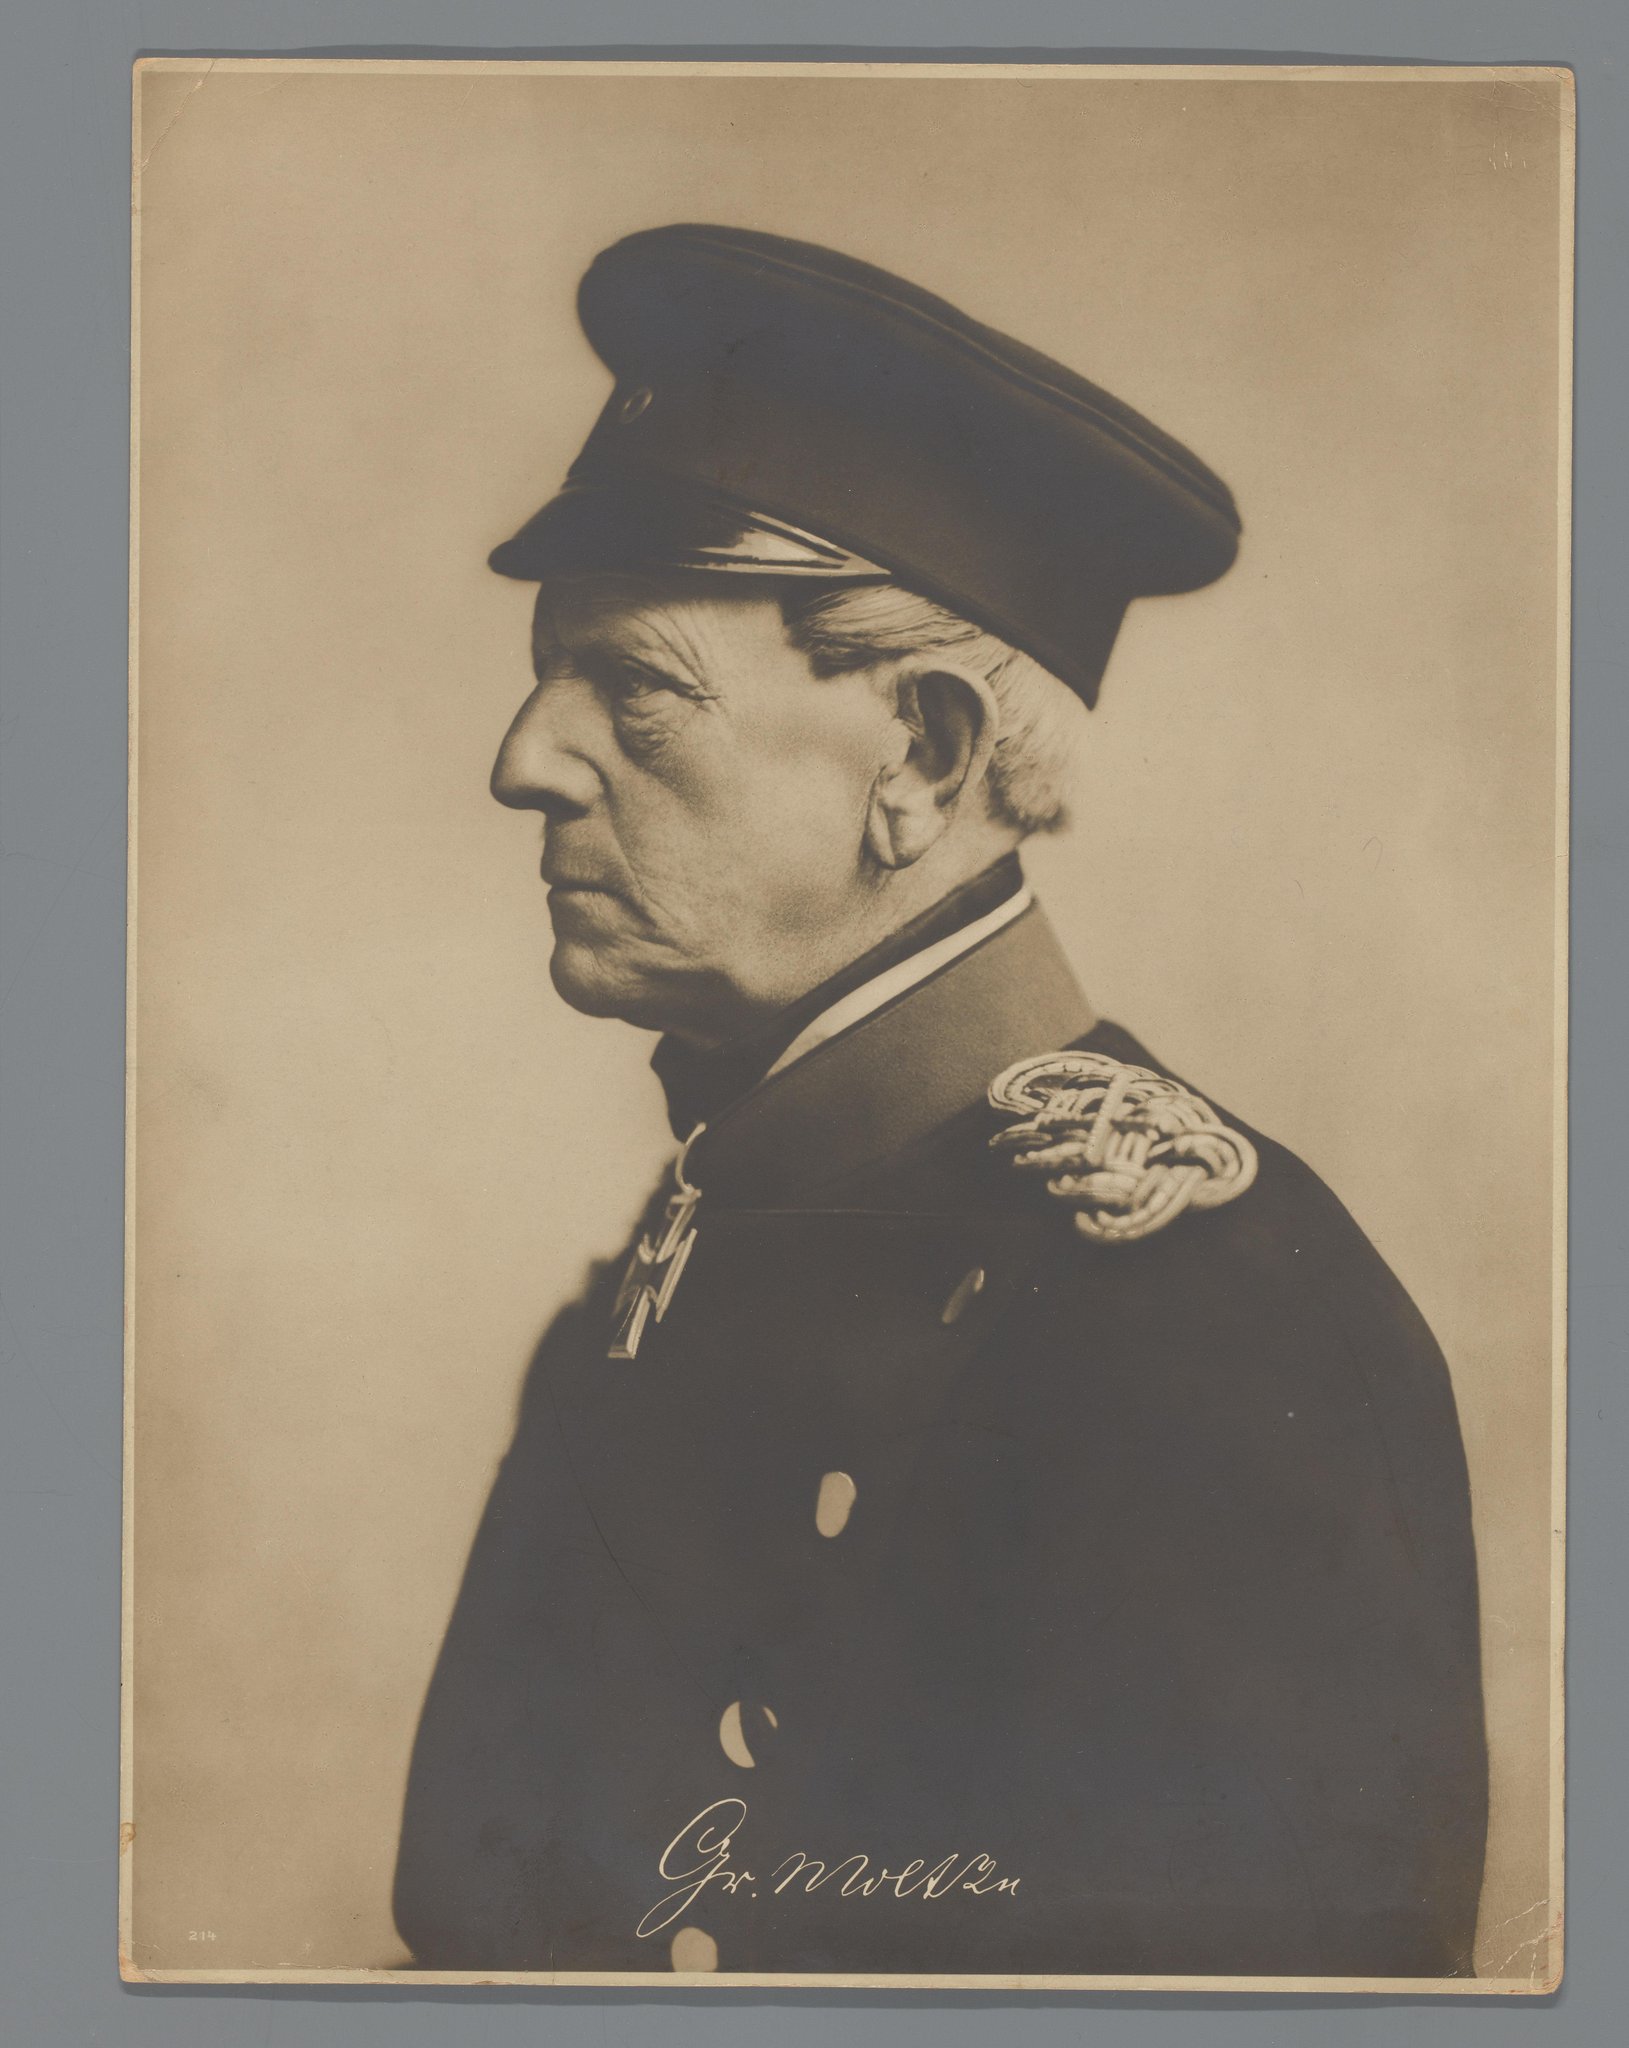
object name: photograph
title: Portret van een Duits militair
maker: Anonymous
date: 1885-1891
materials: paper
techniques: gelatin silver print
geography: germany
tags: commander-in-chief, general, marshal, historical persons, germany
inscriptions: number: ‘214’, signature: ‘Gr. Moltke’